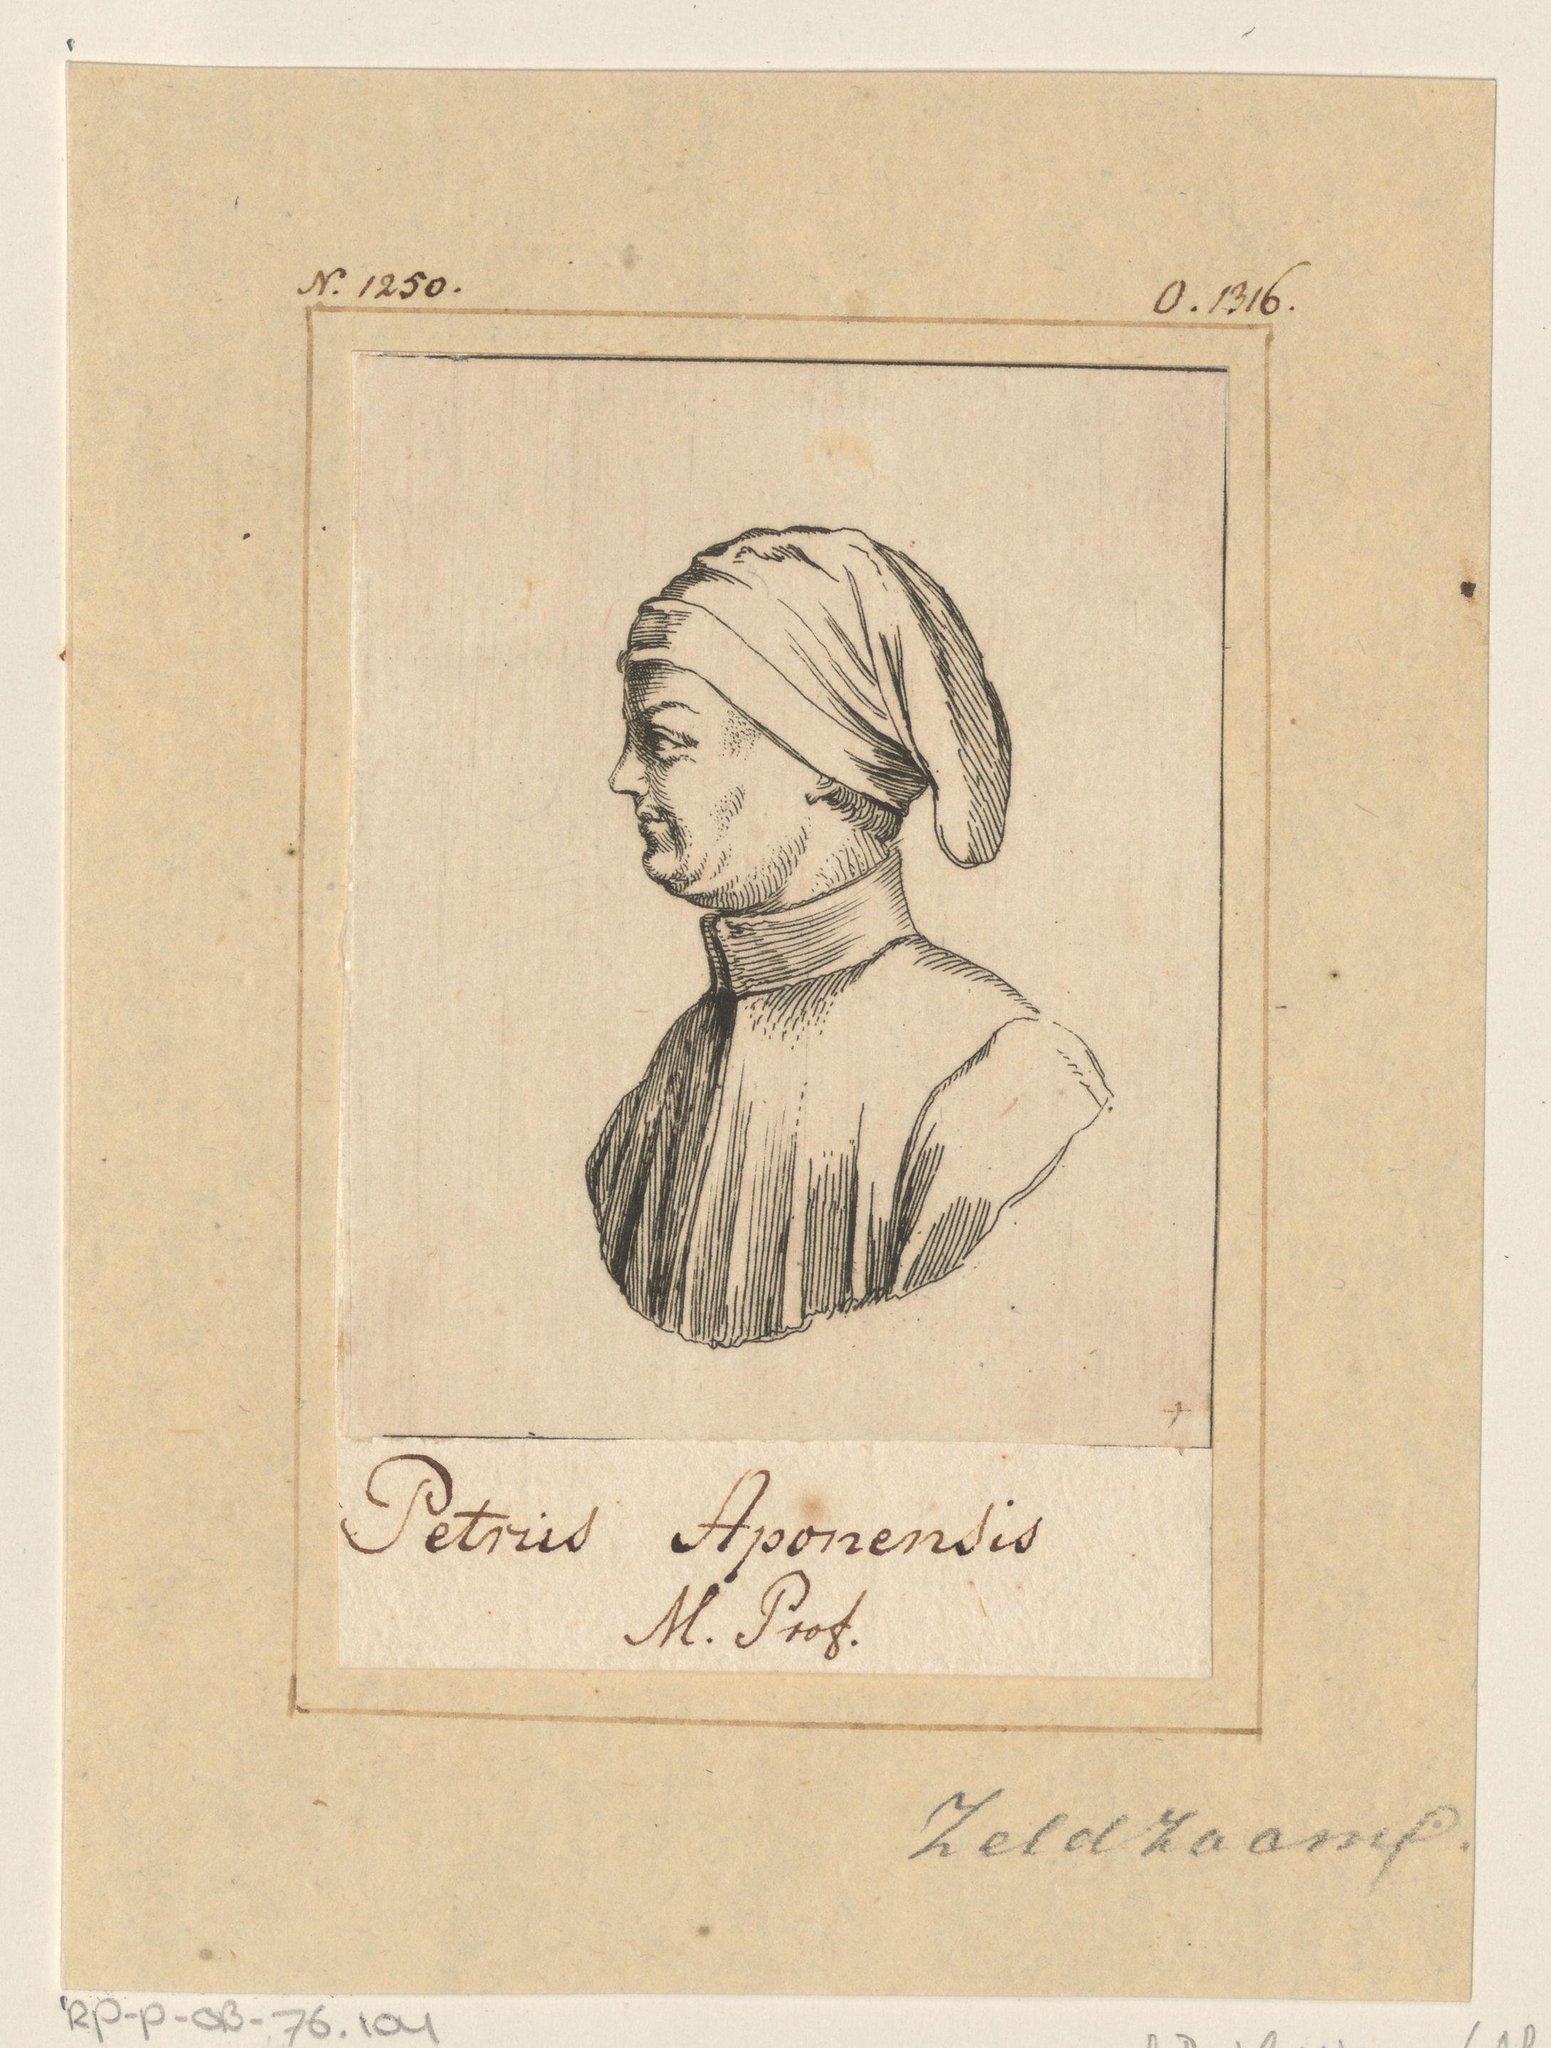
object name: print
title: Portret van Pietro d'Abano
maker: Anonymous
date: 1600-1699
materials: paper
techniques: etching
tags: portrait of a writer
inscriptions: inscription: ‘N. 1250. O. 1316. Petrus Aponensis M. Prof.’, inscription: ‘Zeldzaam.’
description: Portret van Pietro d'Abano in een rechthoekige omlijsting.